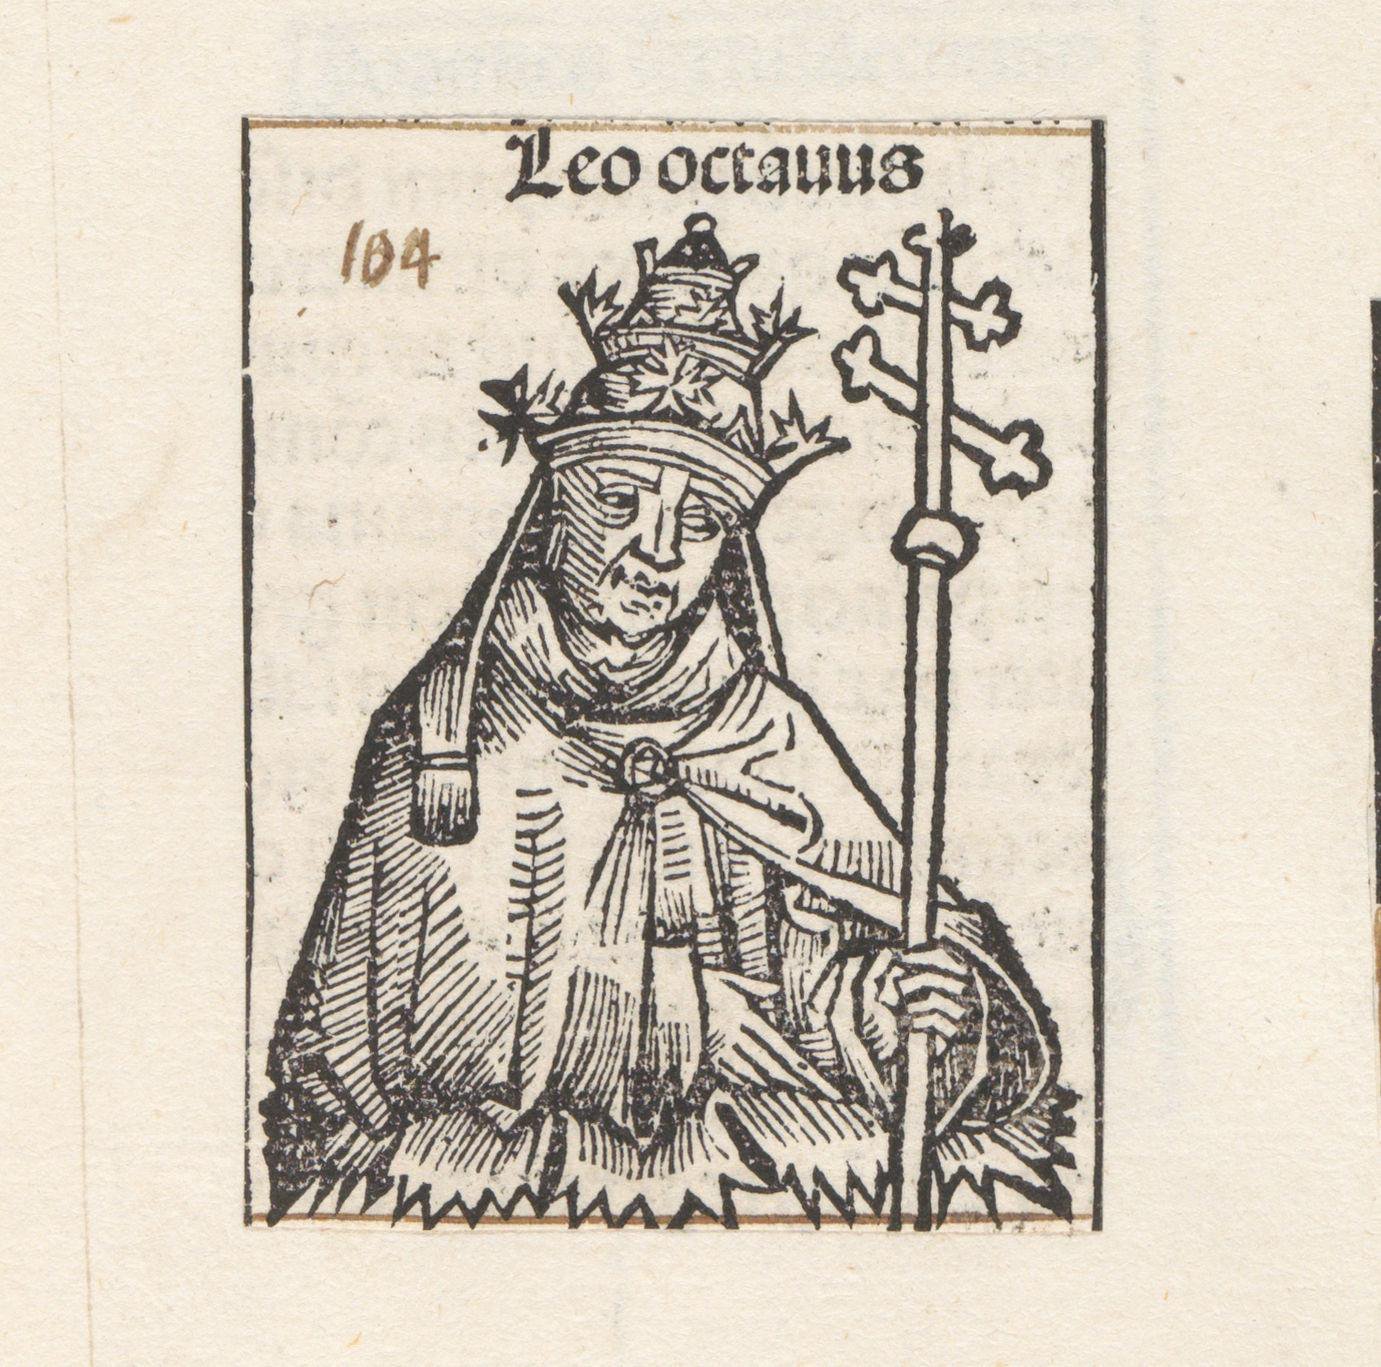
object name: book illustration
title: Leo octavus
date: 1493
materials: paper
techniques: letterpress printing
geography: nuremberg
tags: pope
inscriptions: inscription: ‘104’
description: Een bloemkelk met een paus. Hij draagt een tiara en heeft een staf met een dubbel kruis in zijn handen. De voorstelling is onderdeel van de opeenvolging pausen in de Liber Chronicarum. De tekst identificeert de man als Leo VIII. De prent maakt deel uit van een album.